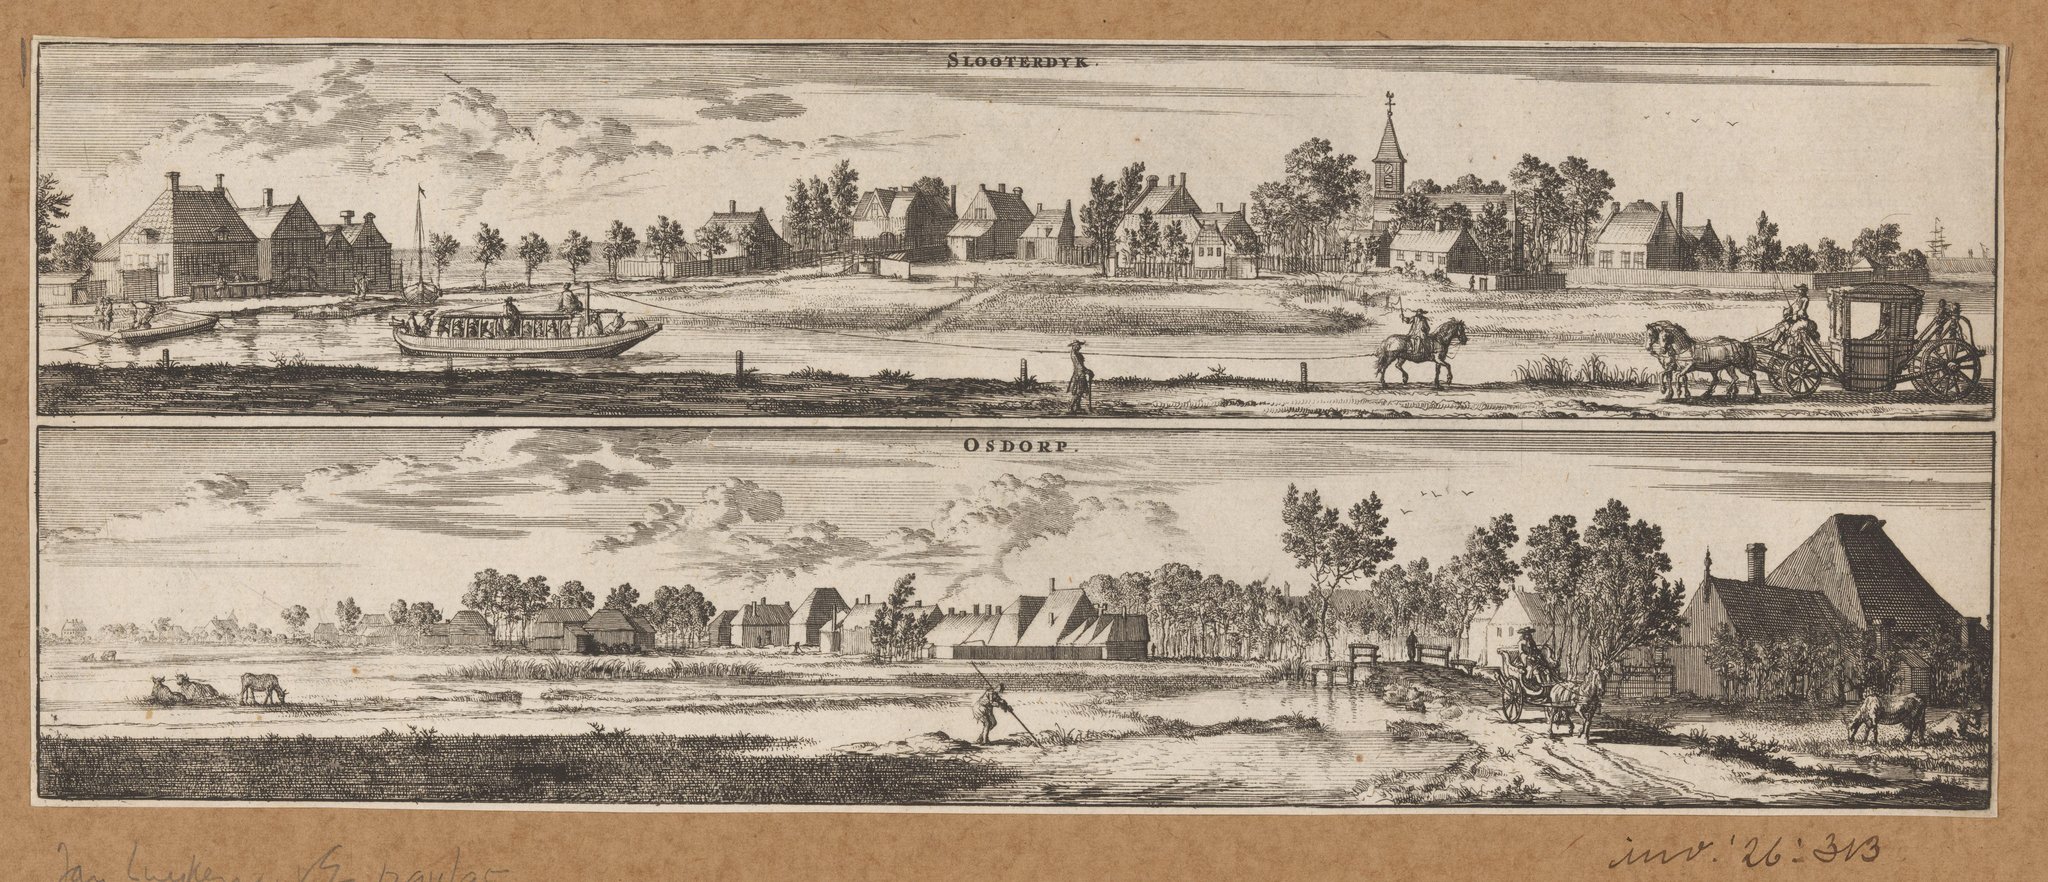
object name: print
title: Slooterdyk / Osdorp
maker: jan luyken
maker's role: draughtsman, print maker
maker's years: 1649-1712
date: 1693-1726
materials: paper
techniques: etching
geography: amsterdam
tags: prospect of village, silhouette of village, sloterdijk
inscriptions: collector's mark: Lugt 2233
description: Prent behoort tot een geheel met vier stadsgezichten van de steden Amstelveen, Sloten, Sloterdijk en Osdorp.